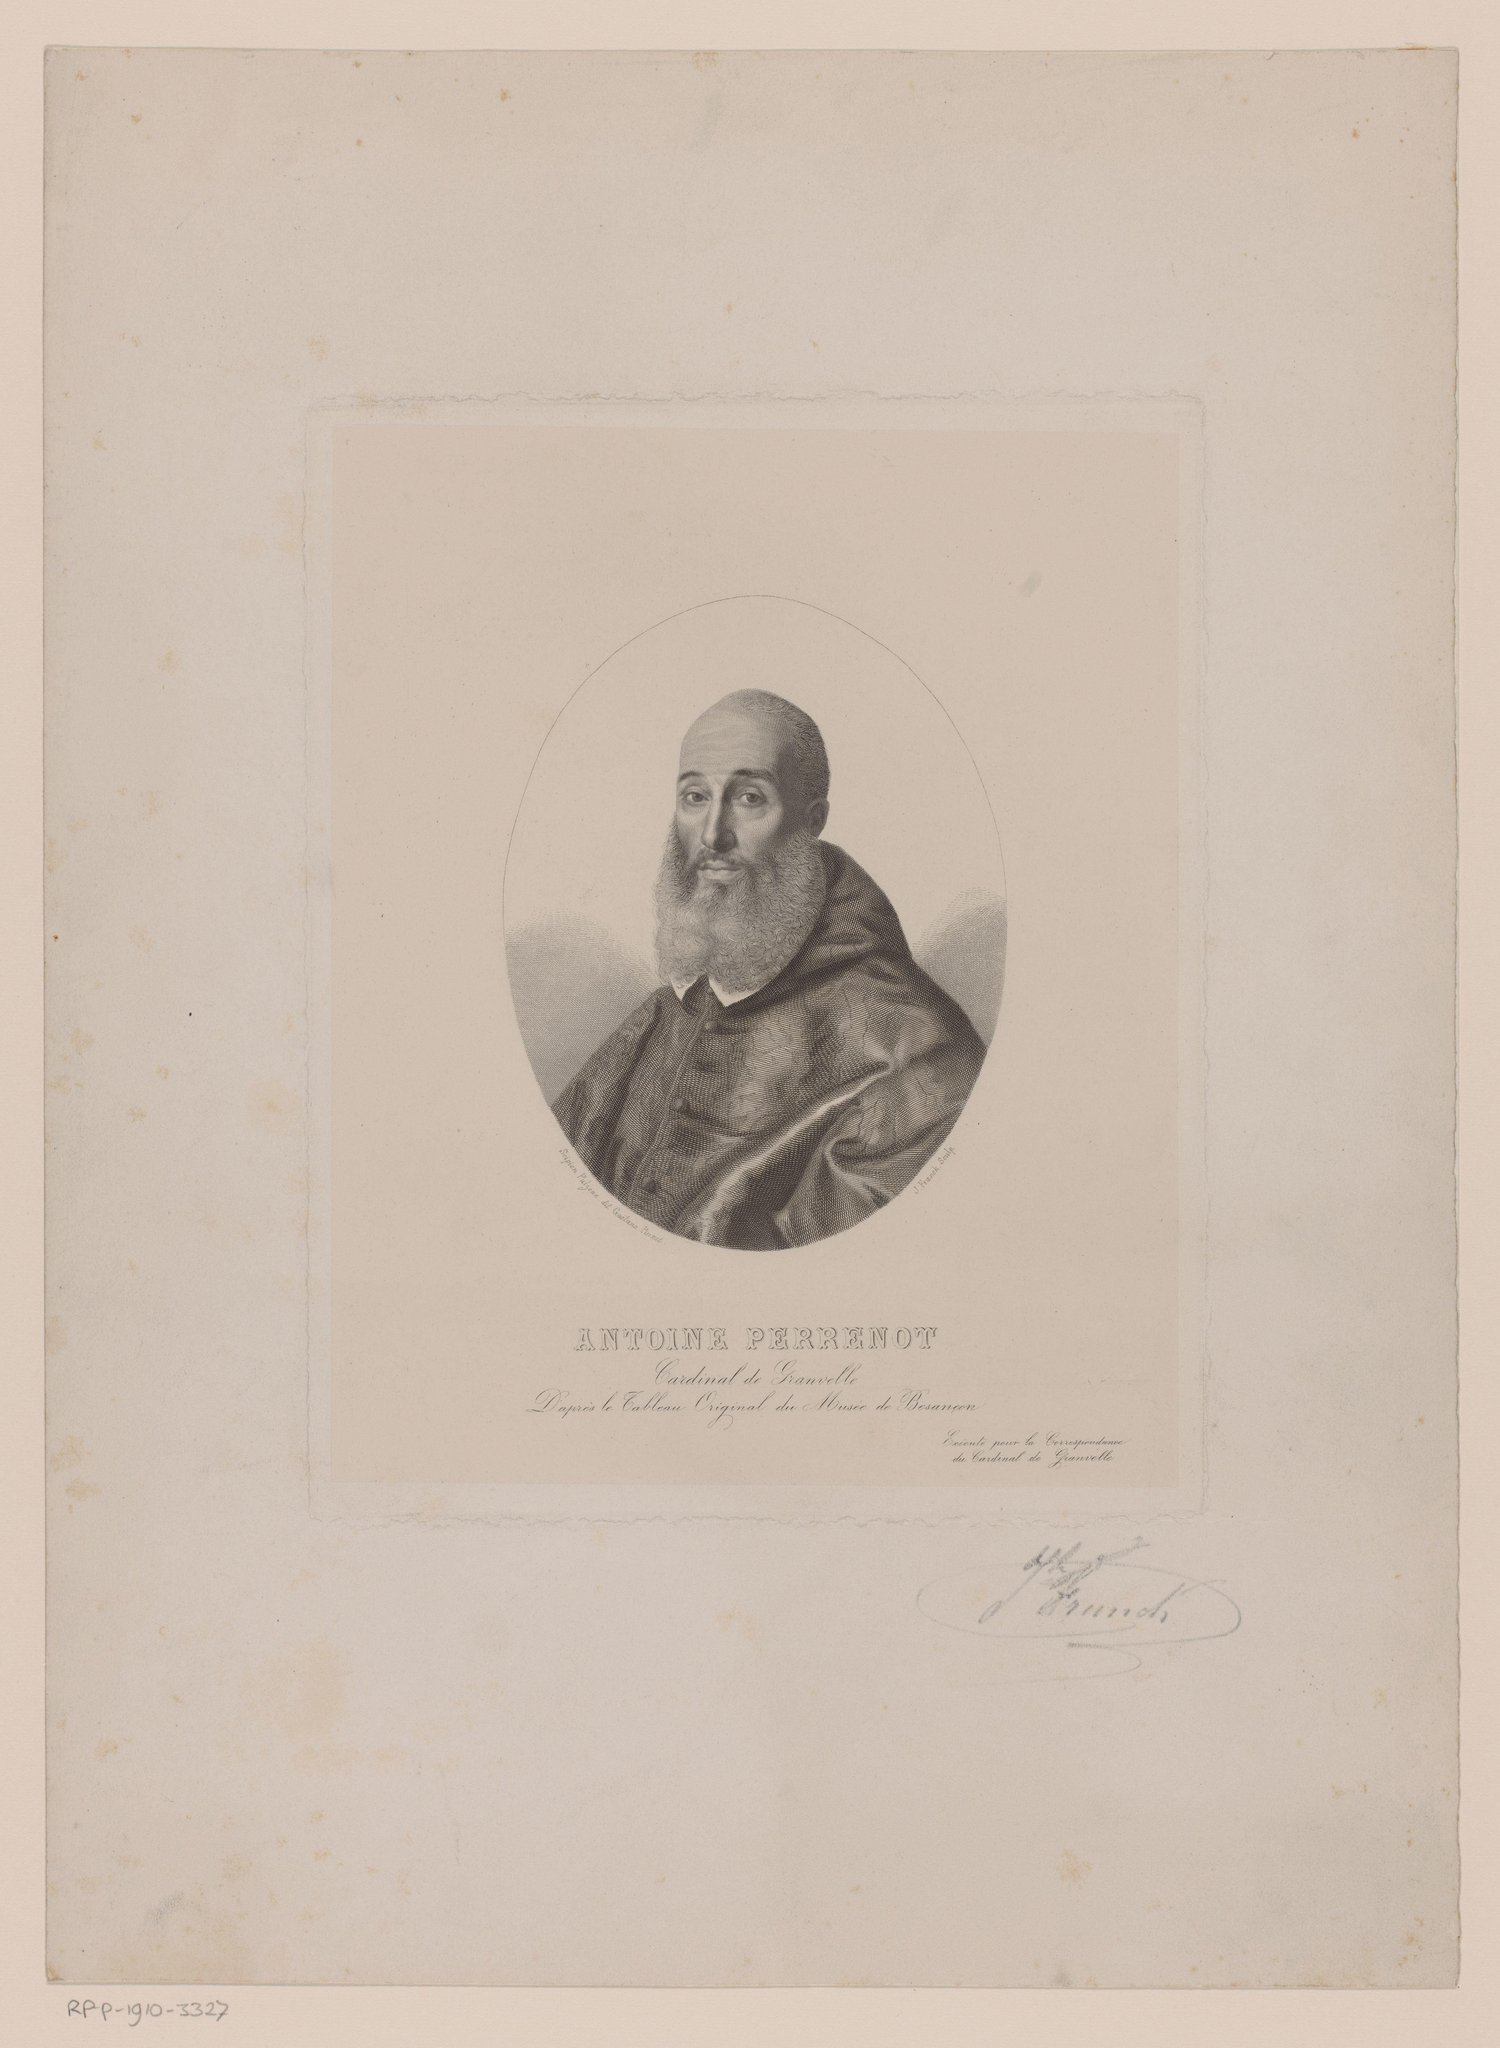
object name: print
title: Portret van Antoine Perrenot de Granvelle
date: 1835-1883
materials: paper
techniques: engraving, etching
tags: antoine perrenot de granvelle, cardinal, adult man, historical persons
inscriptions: collector's mark: Lugt 2228